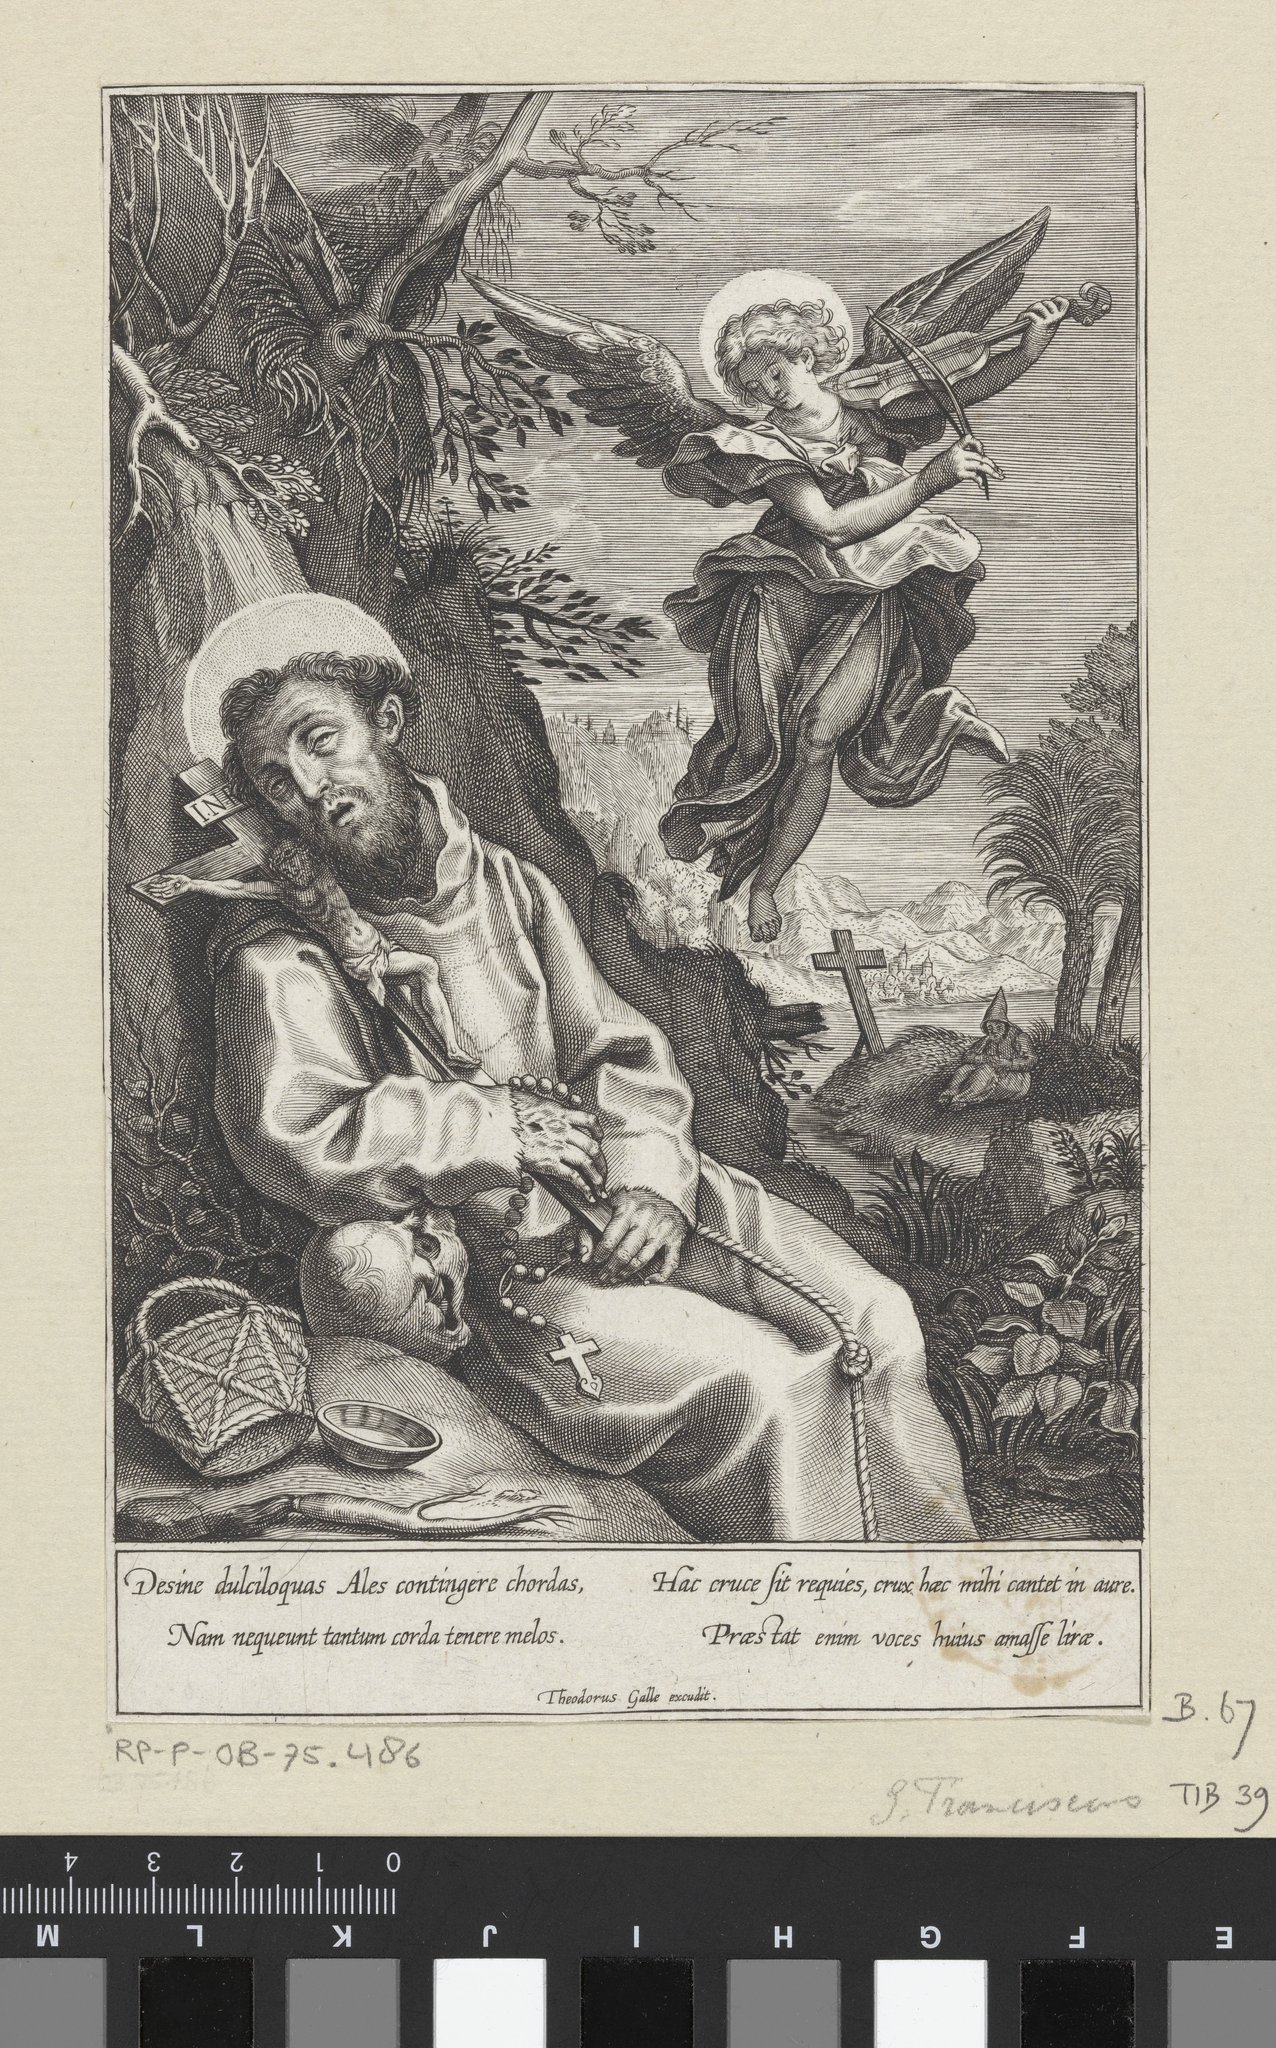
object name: print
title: De heilige Franciscus getroost door een musicerende engel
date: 1581-1633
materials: paper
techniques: engraving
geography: antwerp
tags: an angel playing the violin appears to st. francis of assisi; francis perhaps on his sickbed, deathbed, or meditating in the open air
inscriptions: collector's mark: Lugt 240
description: De zieke heilige Franciscus zit met een crucifix, een rozenkrans en een schedel tegen een rotswand. In de lucht verschijnt een engel die een viool bespeelt om Franciscus te troosten. Tekst in ondermarge.